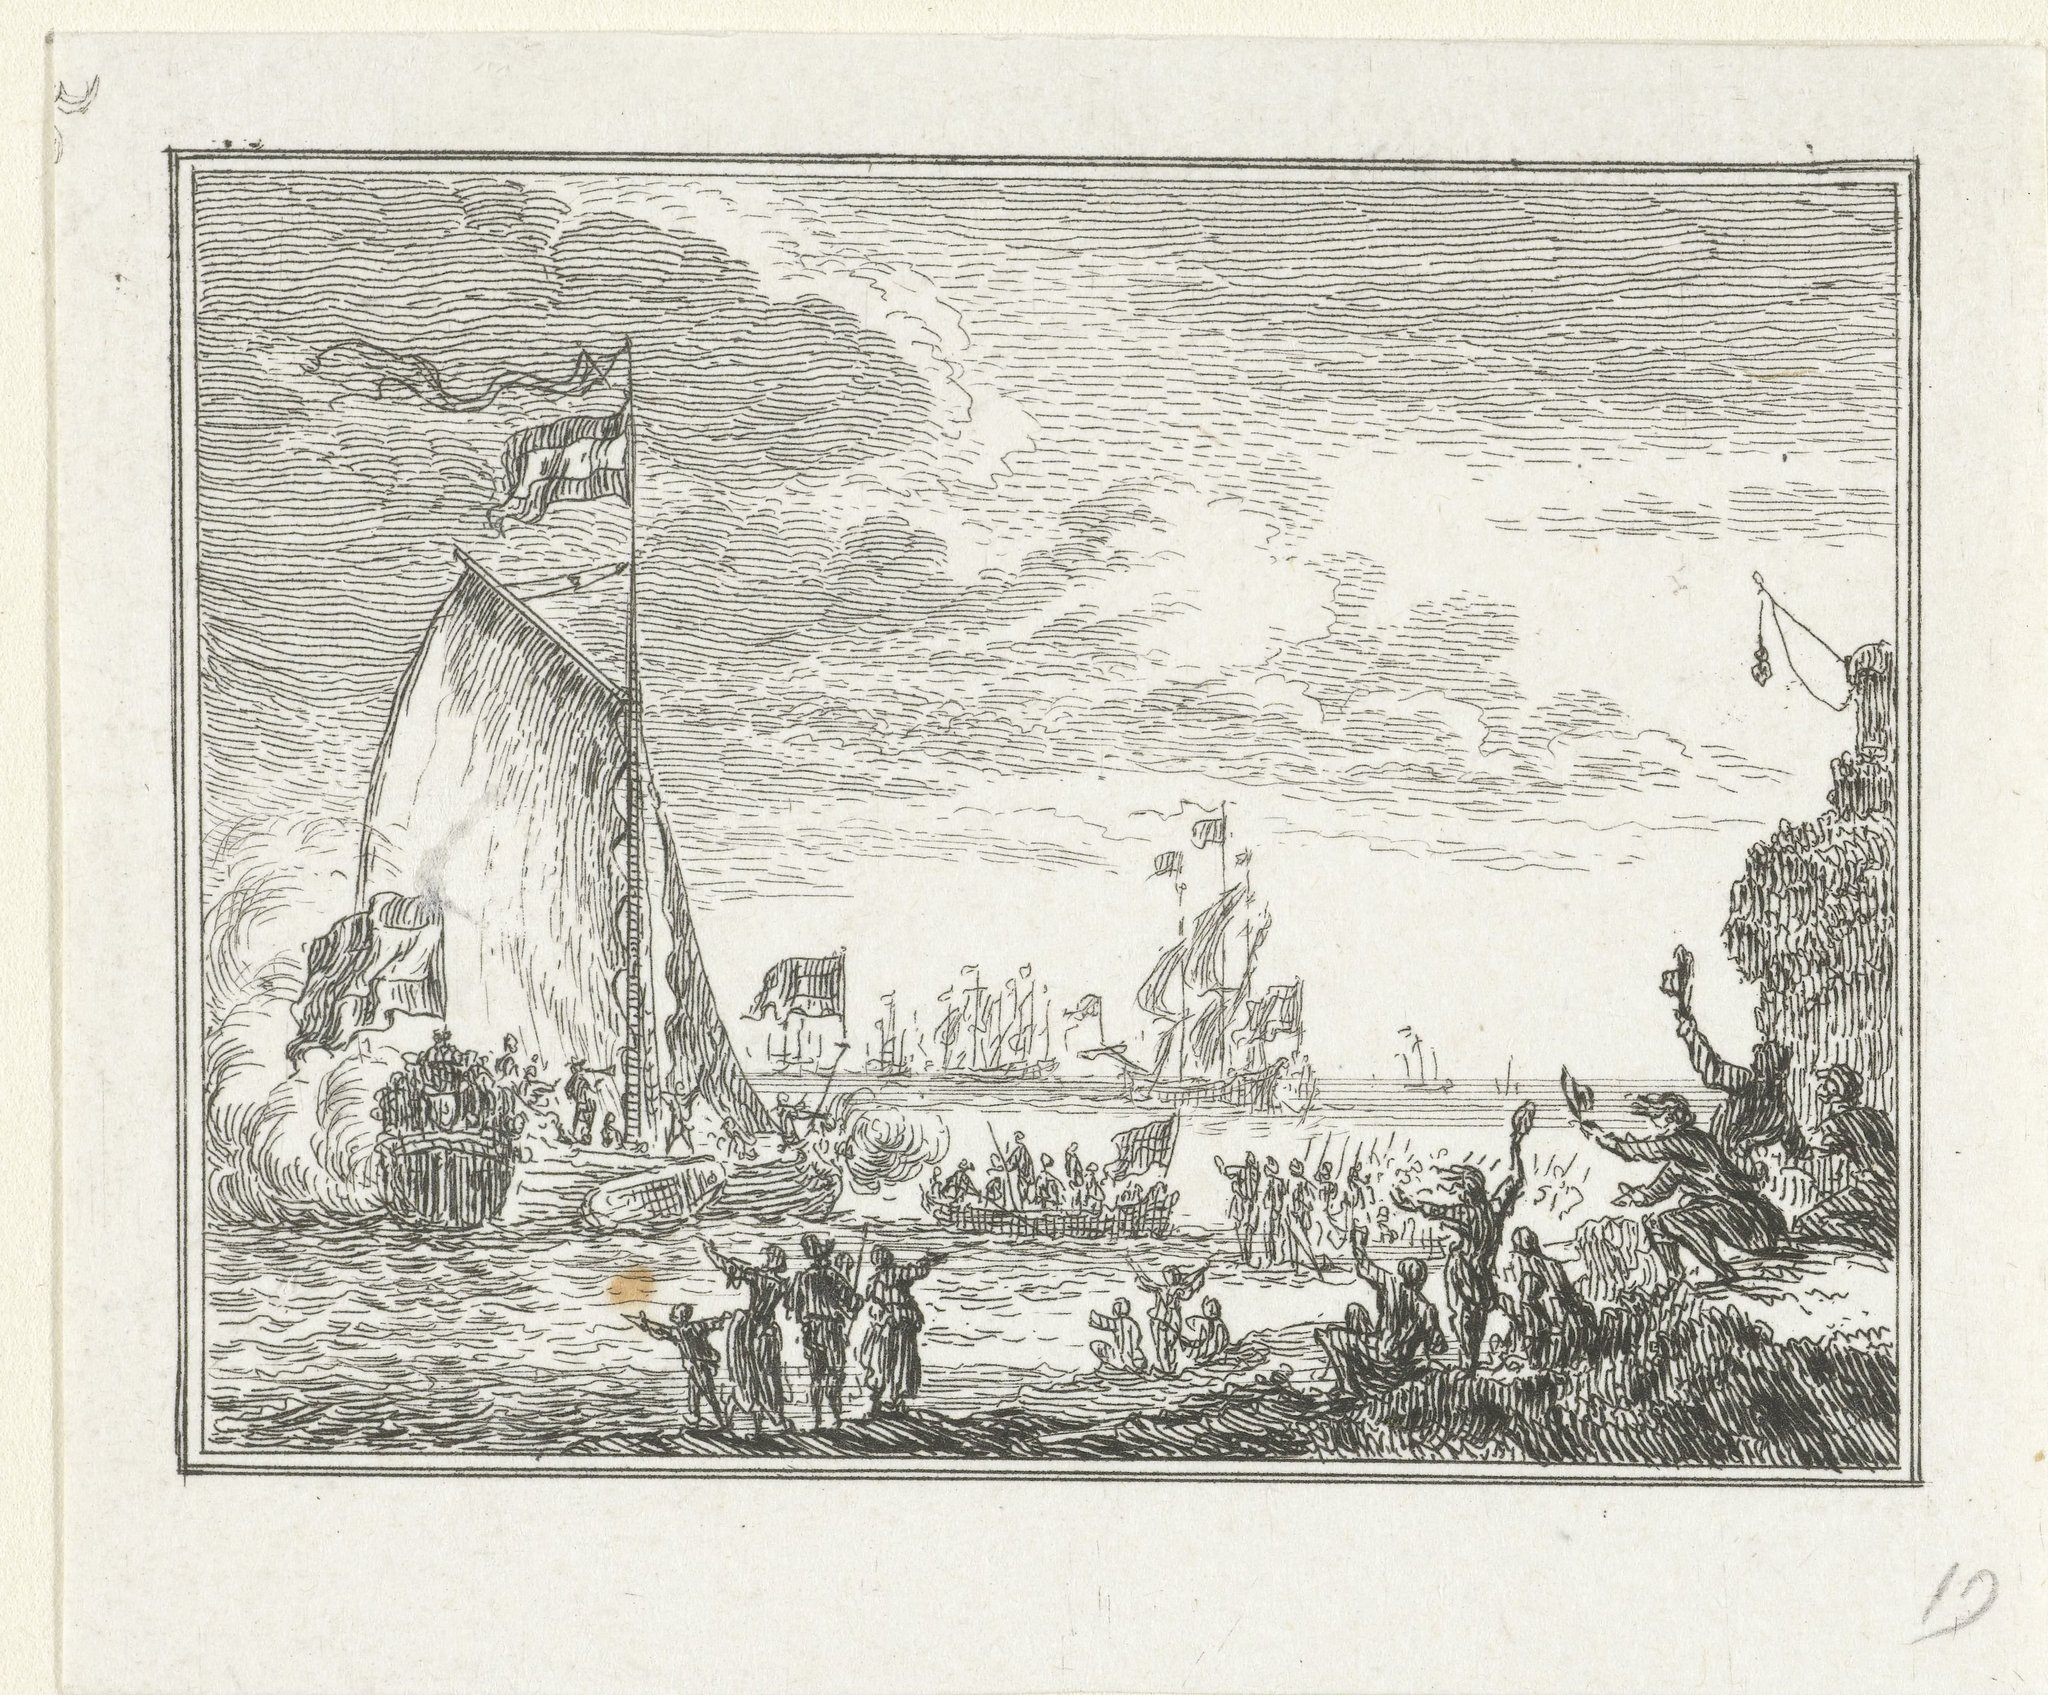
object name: print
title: Aankomst van Willibrordus, 691, en Bonifatius in Dokkum gedood, 755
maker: simon fokke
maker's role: draughtsman, print maker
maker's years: 1712-1784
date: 1784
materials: paper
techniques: etching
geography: amsterdam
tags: the 'apostle of frisia' and archbishop of utrecht, willibrord (of echternach); possible attributes: cask (barrel), well (fountain), child (on a book), model of church, stone bottles, spreading the gospel; missionary work, martyrdom, suffering, misfortune, death of st. boniface, netherlands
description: Voorstellingen uit de vaderlandse geschiedenis. Boven: Aankomst van bisschop Willibrordus in het jaar 691. Links van Bonifatius vindt een heidense offerceremonie plaats. Onder: Bonifatius door gewapende figuren vermoord op 5 juni 754. Zijn staf en mijter liggen naast hem op de grond. Twee voorstellingen van één plaat, respectievelijk genummerd: VII en VII.